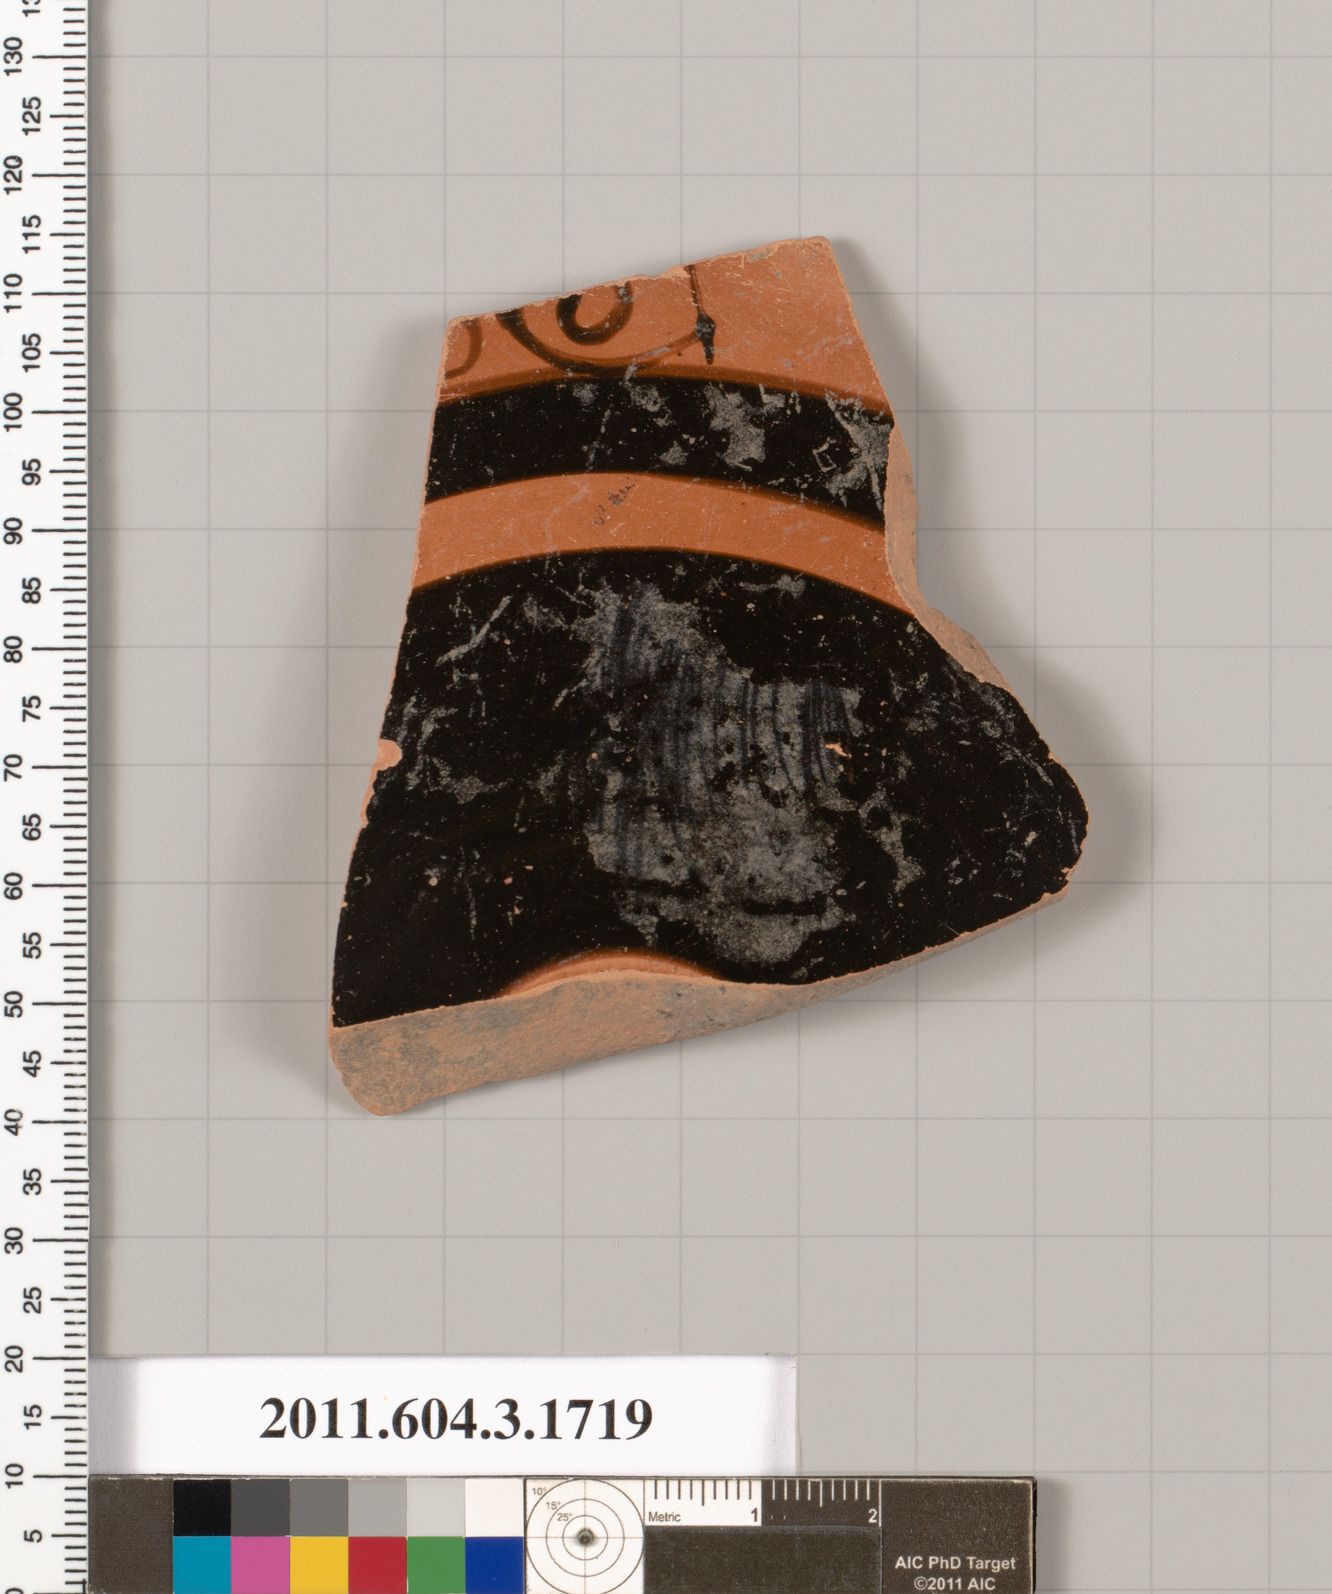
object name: kylix fragment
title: Terracotta fragment of a kylix: Lip cup (drinking cup)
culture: greek, attic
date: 550-526 BCE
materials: terracotta